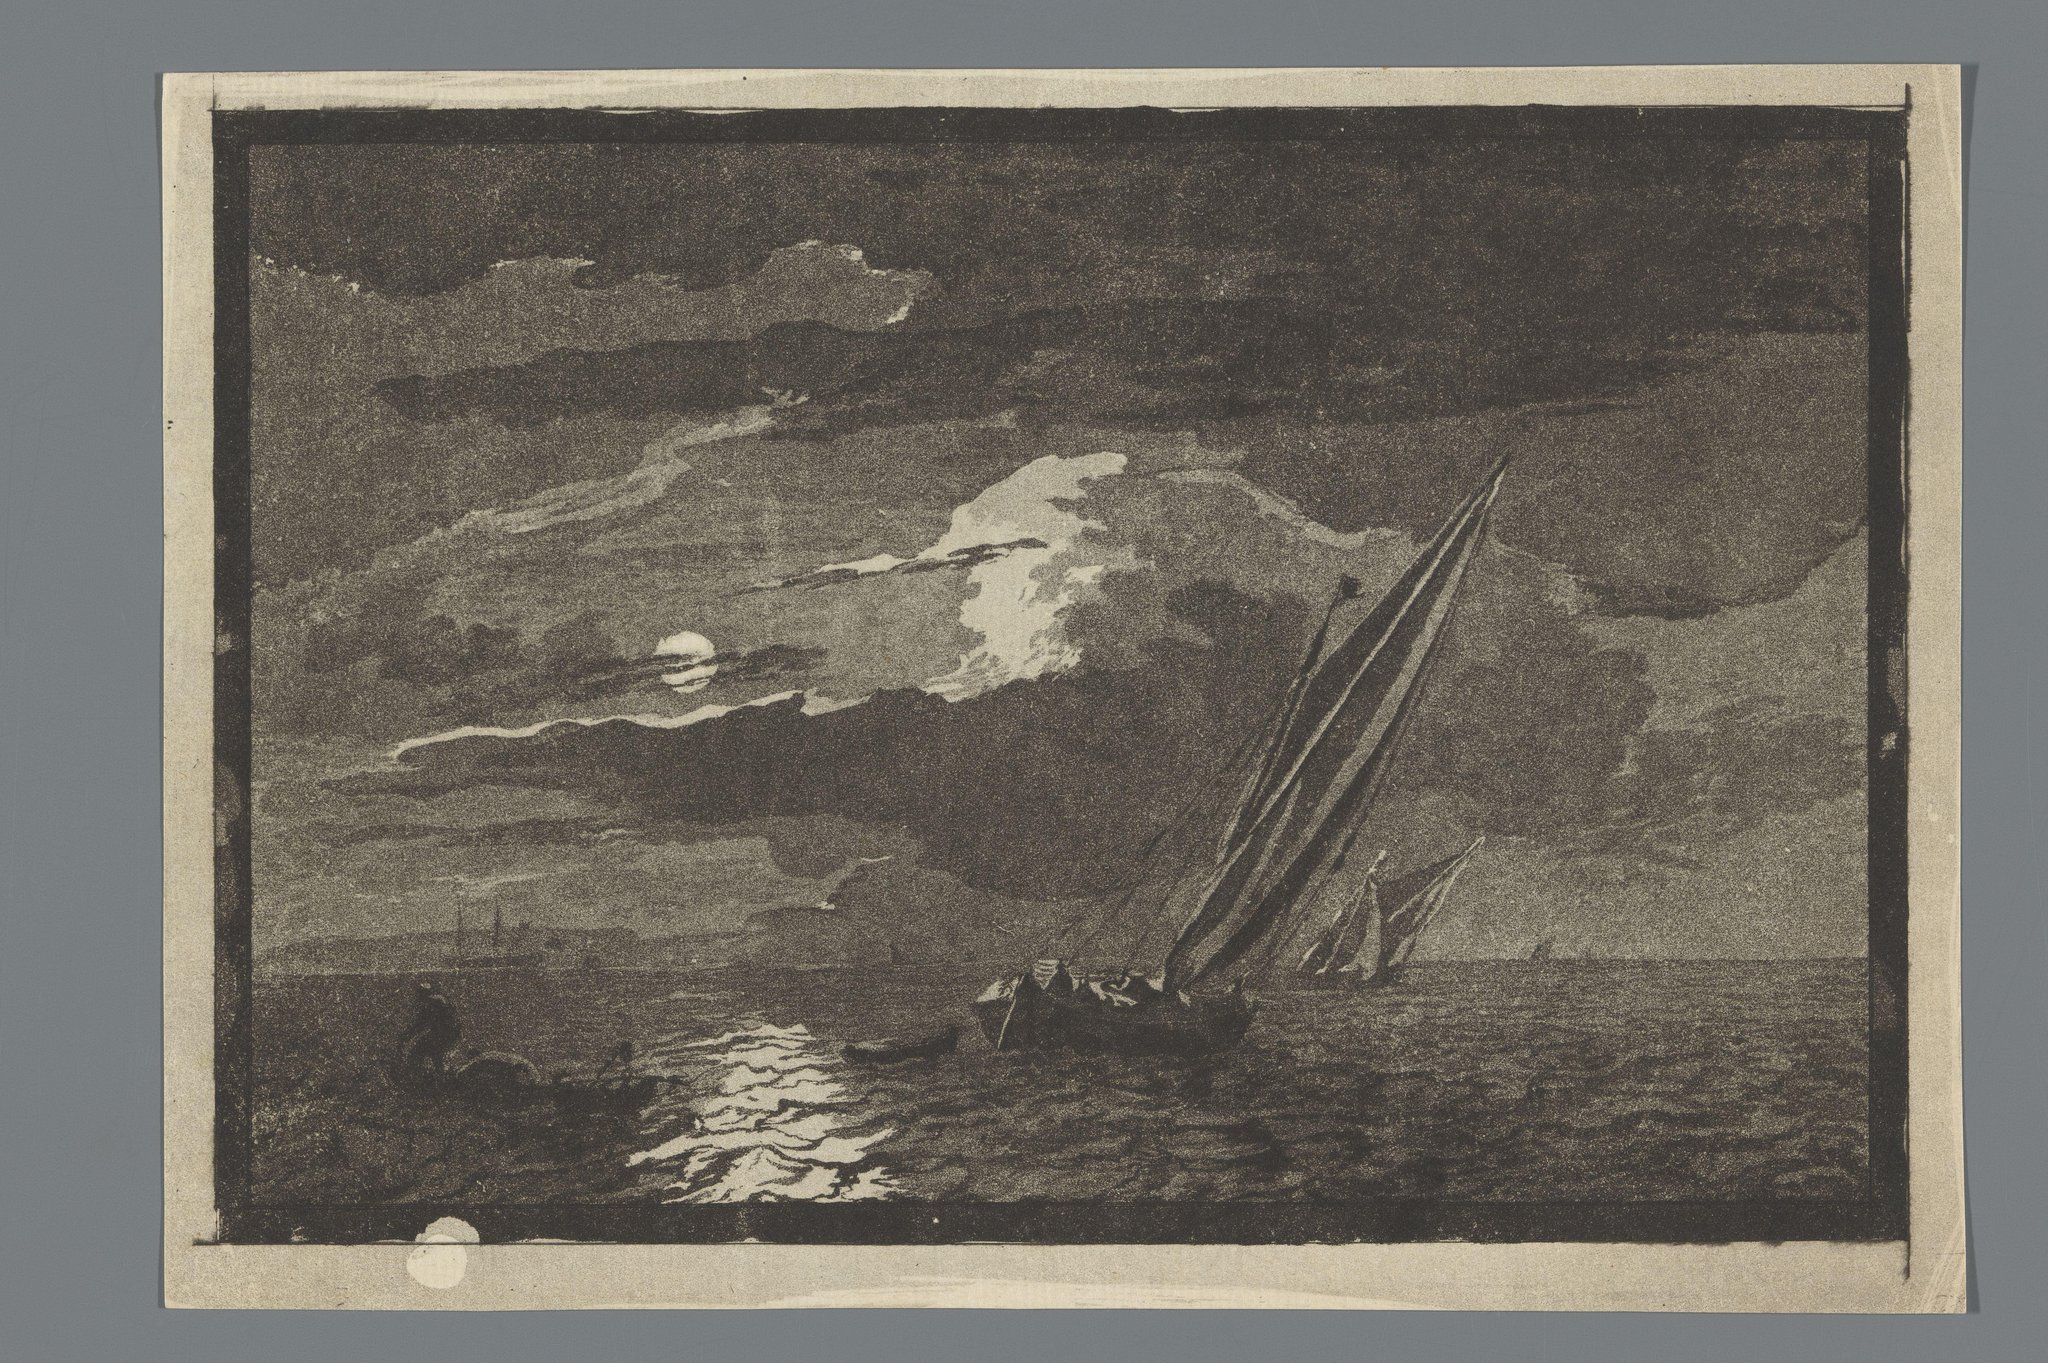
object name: print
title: Zeegezicht met volle maan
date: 1779-1781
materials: paper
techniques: transfer, print drawing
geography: amsterdam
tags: sailing-ship, sailing-boat, moonlight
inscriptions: collector's mark: ‘RIJKS / MUSM’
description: Op zee varen twee zeilschepen. Een visser haalt vanuit een sloep zijn netten binnen. De prent ligt los in een album, zie blad 33.